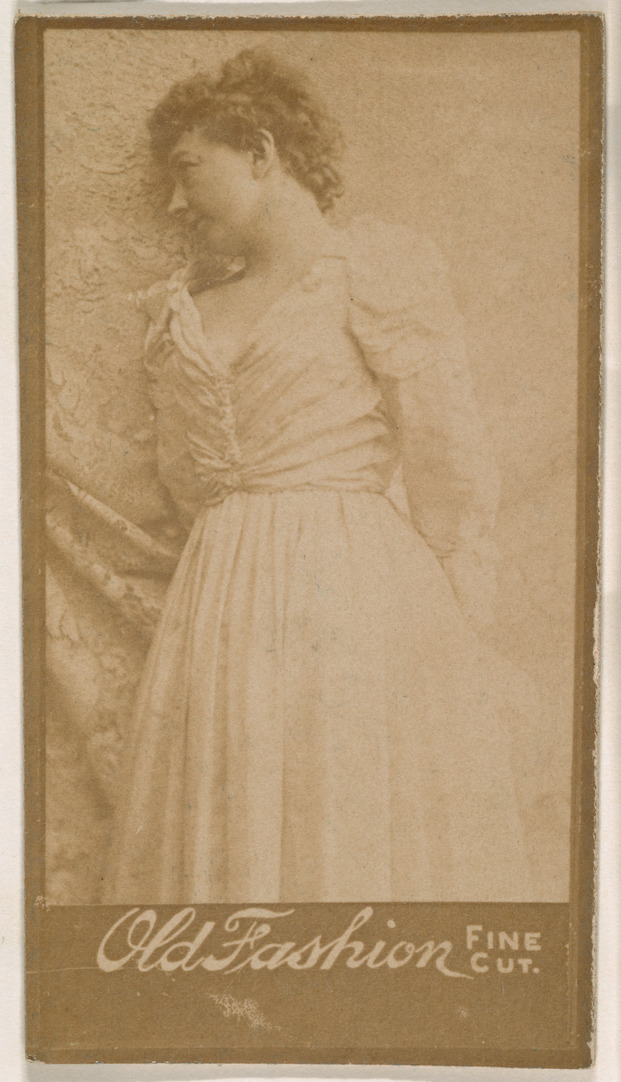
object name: photograph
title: Actress leaning against studio curtain, from the Actresses series (N664) promoting Old Fashion Fine Cut Tobacco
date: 1888-1890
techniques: albumen silver print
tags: women,actresses